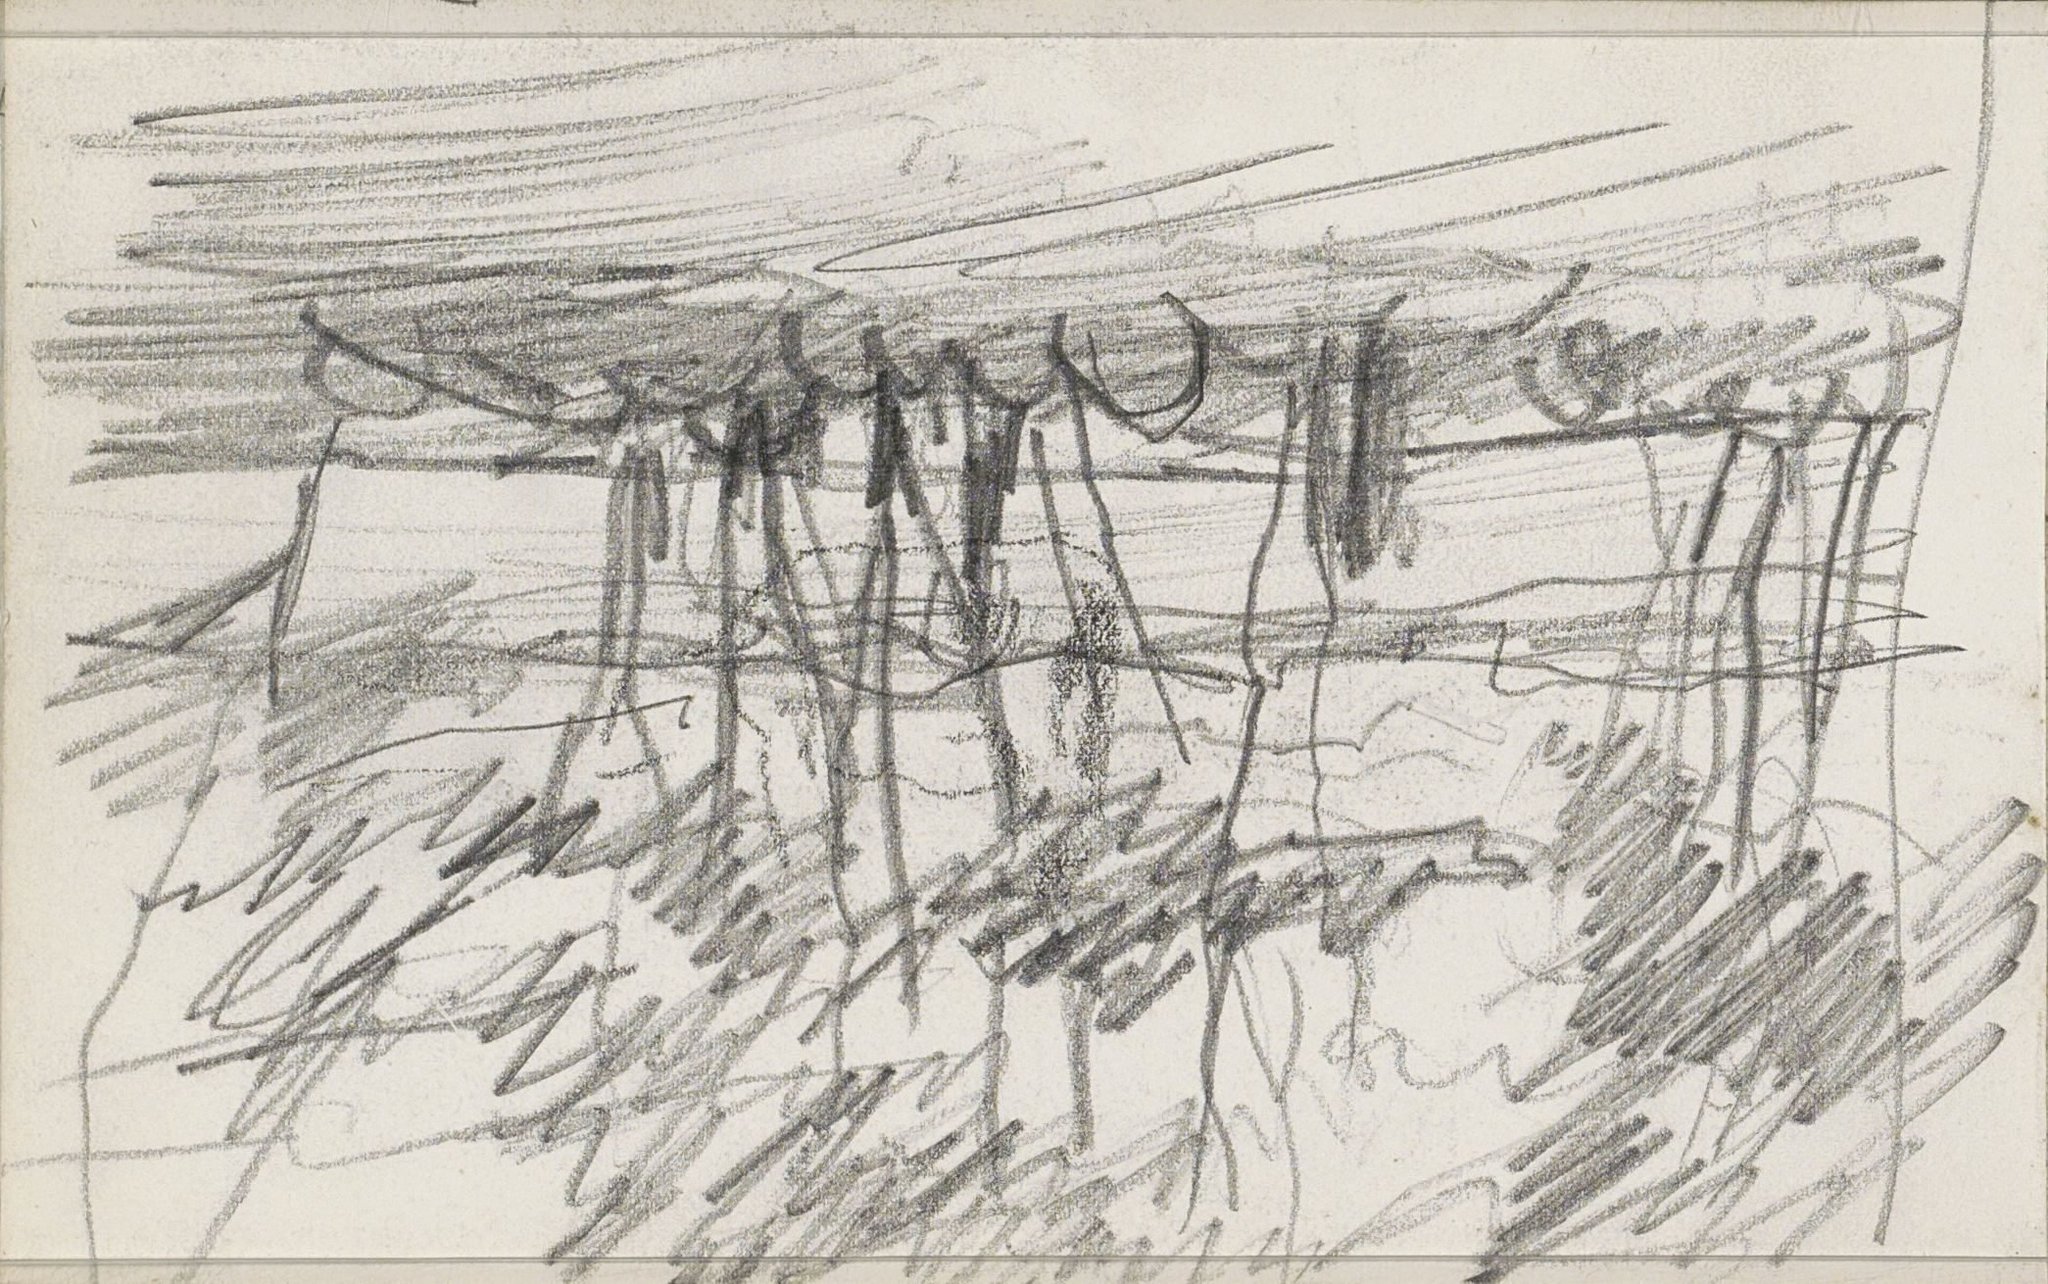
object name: sketchbook leaf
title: Rij bomen aan een waterkant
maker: anton mauve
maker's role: draughtsman, painter, print maker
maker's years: 1838-1888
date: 1848-1888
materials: chalk, paper, pencil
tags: trees, landscapes with waters, waterscapes, seascapes (in the temperate zone)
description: Blad 1 verso uit een schetsboek met 43 bladen.